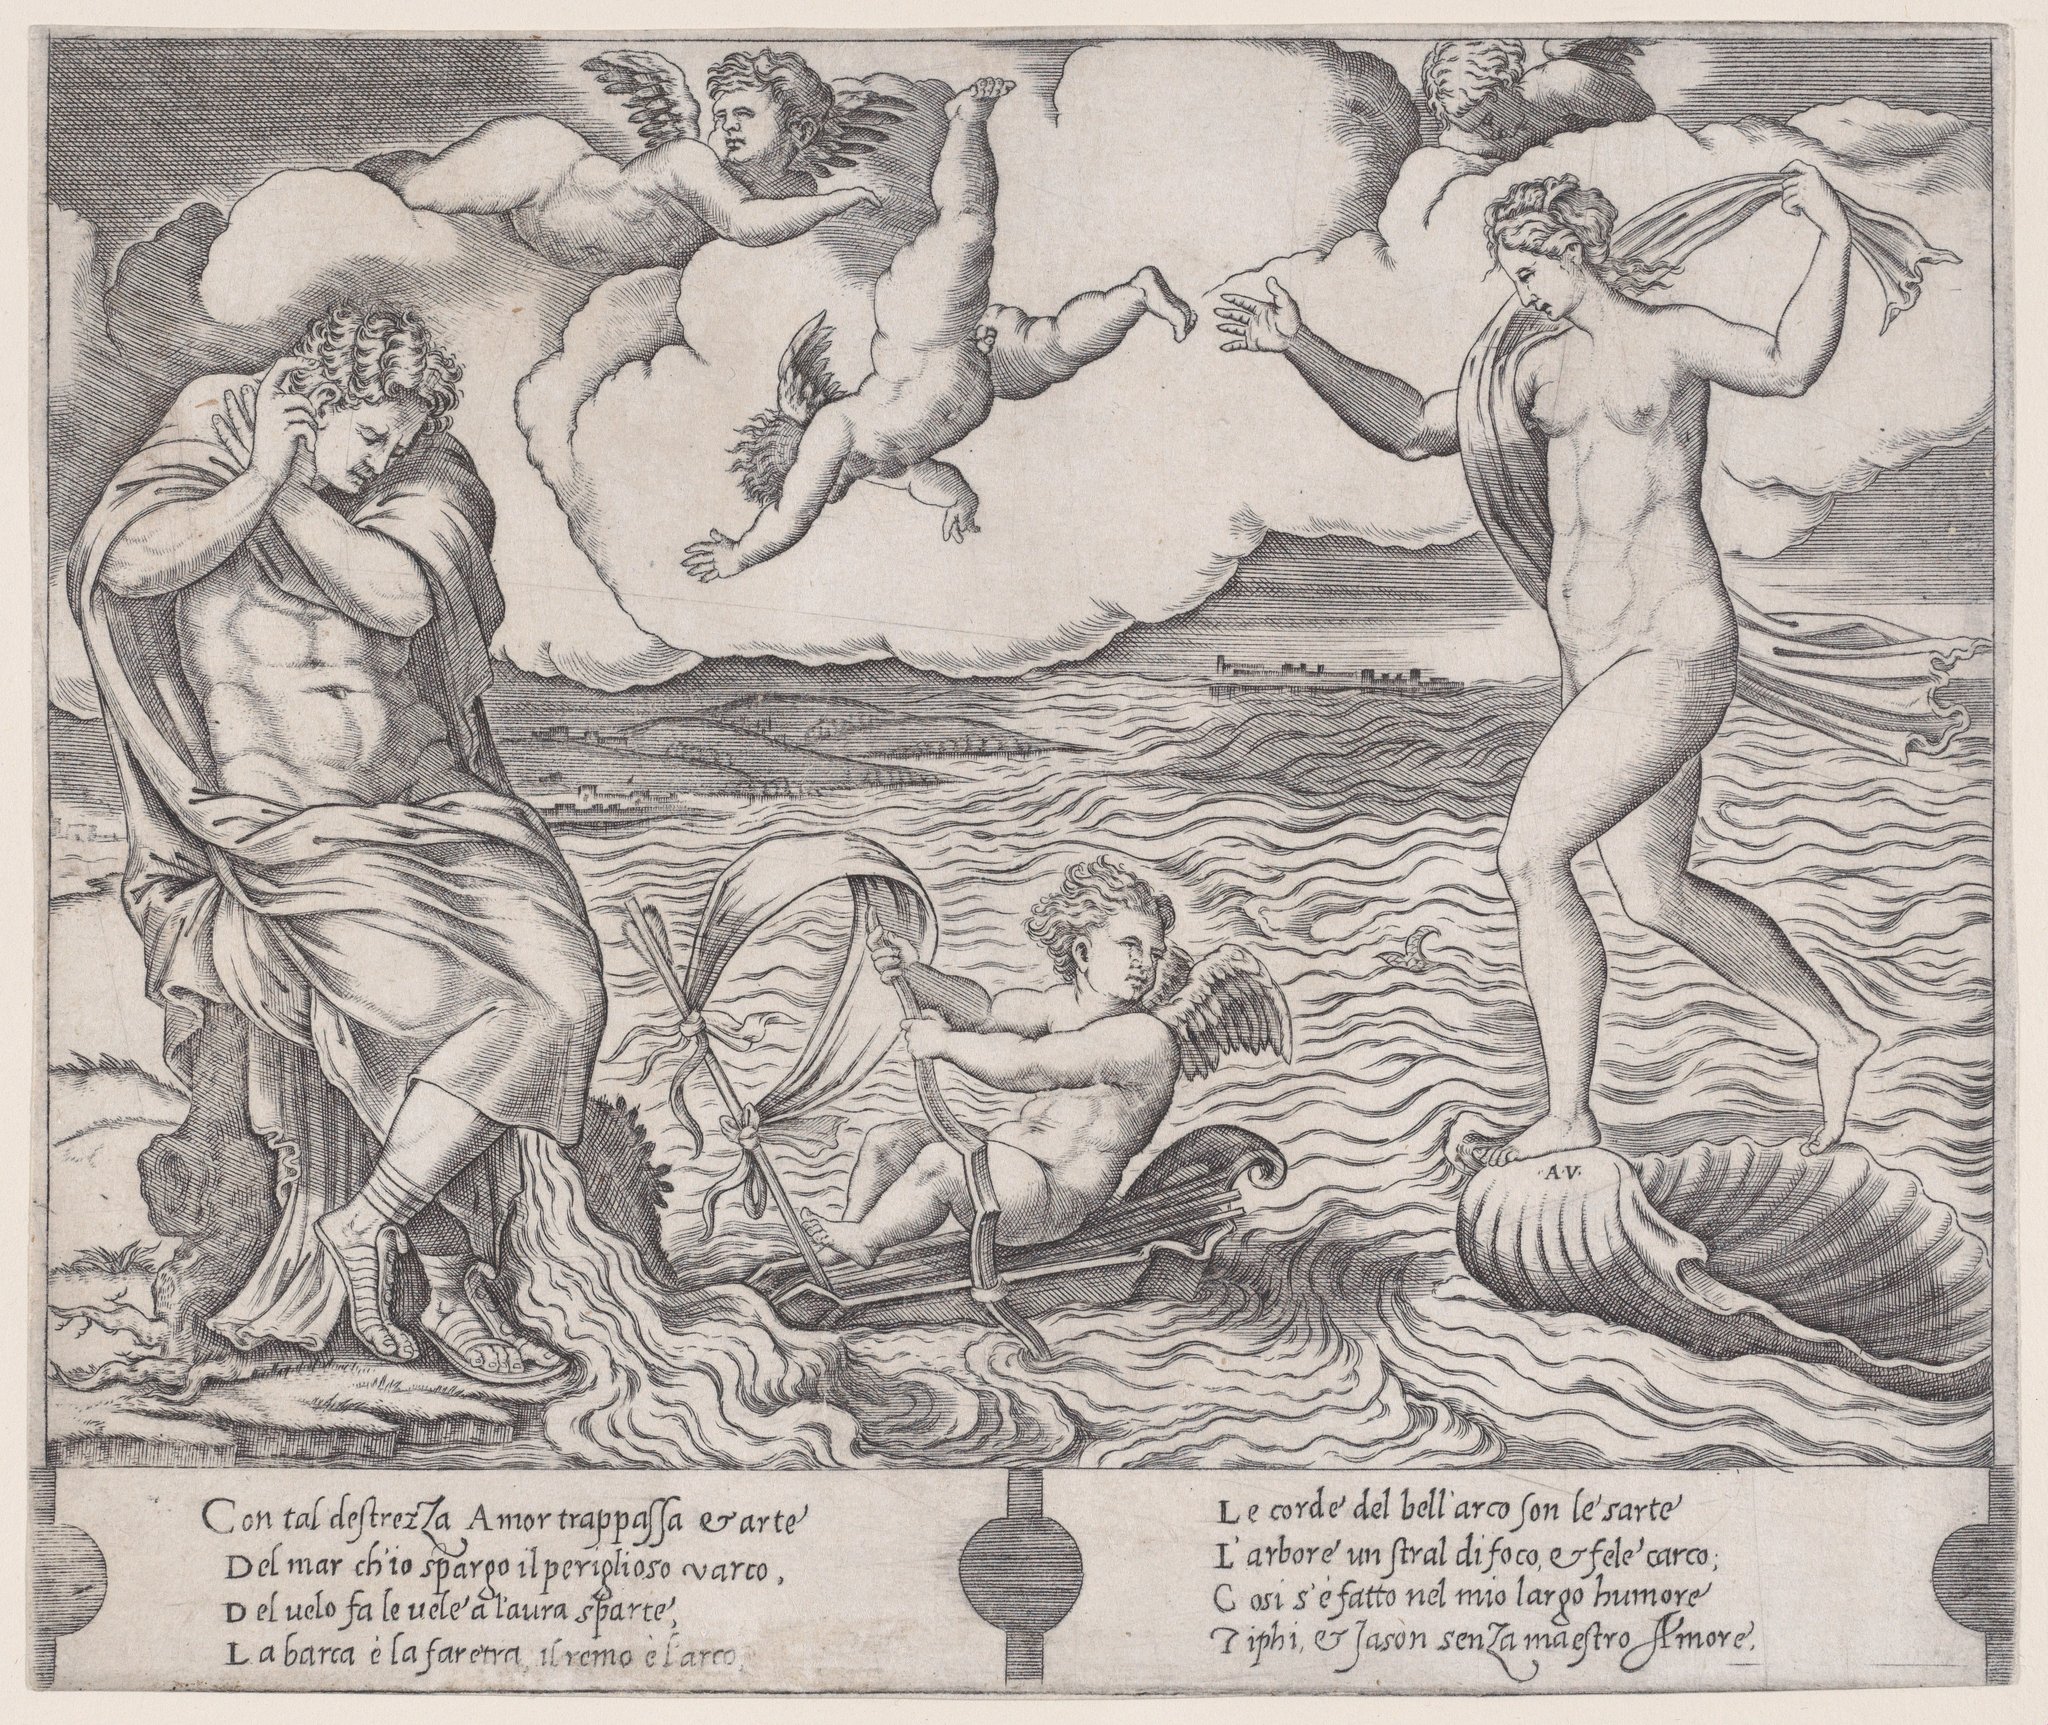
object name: print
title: Eros in the Sea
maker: agostino veneziano (agostino dei musi)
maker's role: artist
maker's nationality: italian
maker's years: 1490-1536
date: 1514-1536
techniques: engraving